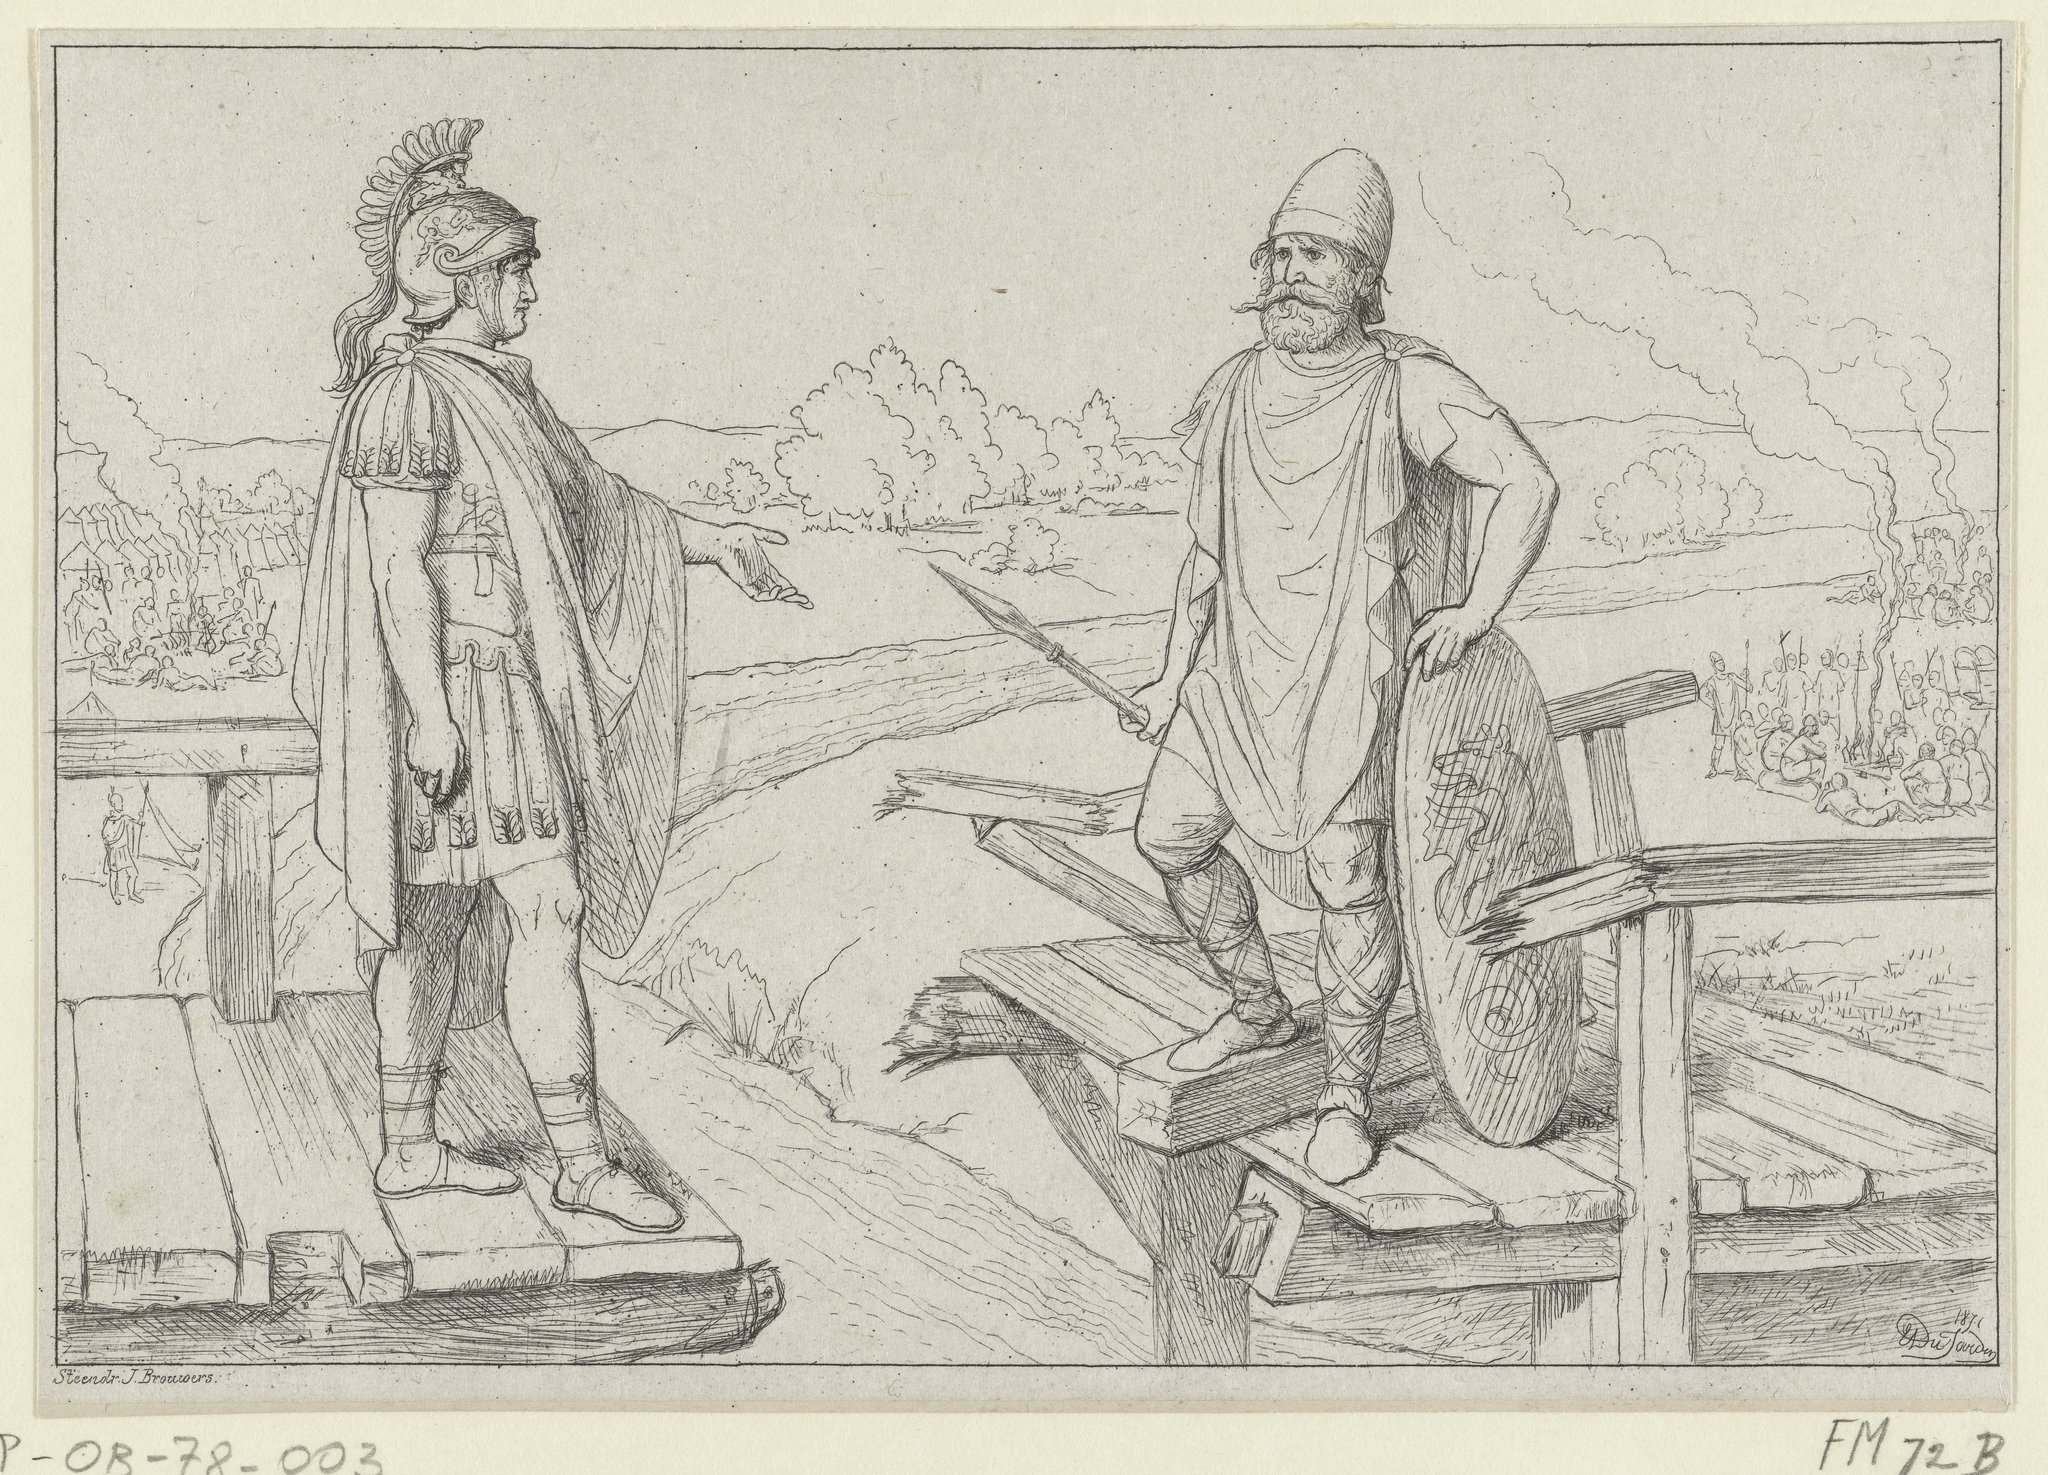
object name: print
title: Civilis en Cerialis onderhandelen op de afgebroken brug, 69-70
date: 1880-1889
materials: paper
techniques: lithograph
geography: netherlands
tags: peace negotiations, extinct, 'historical' peoples (with name), netherlands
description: Civilis en Cerialis onderhandelen en sluiten vrede op de afgebroken brug. Volgens een uitgeknipte tekst die achter de prent is geplakt staat deze plaat tegenover de titel van het eerste deel (van een onbekend werk).